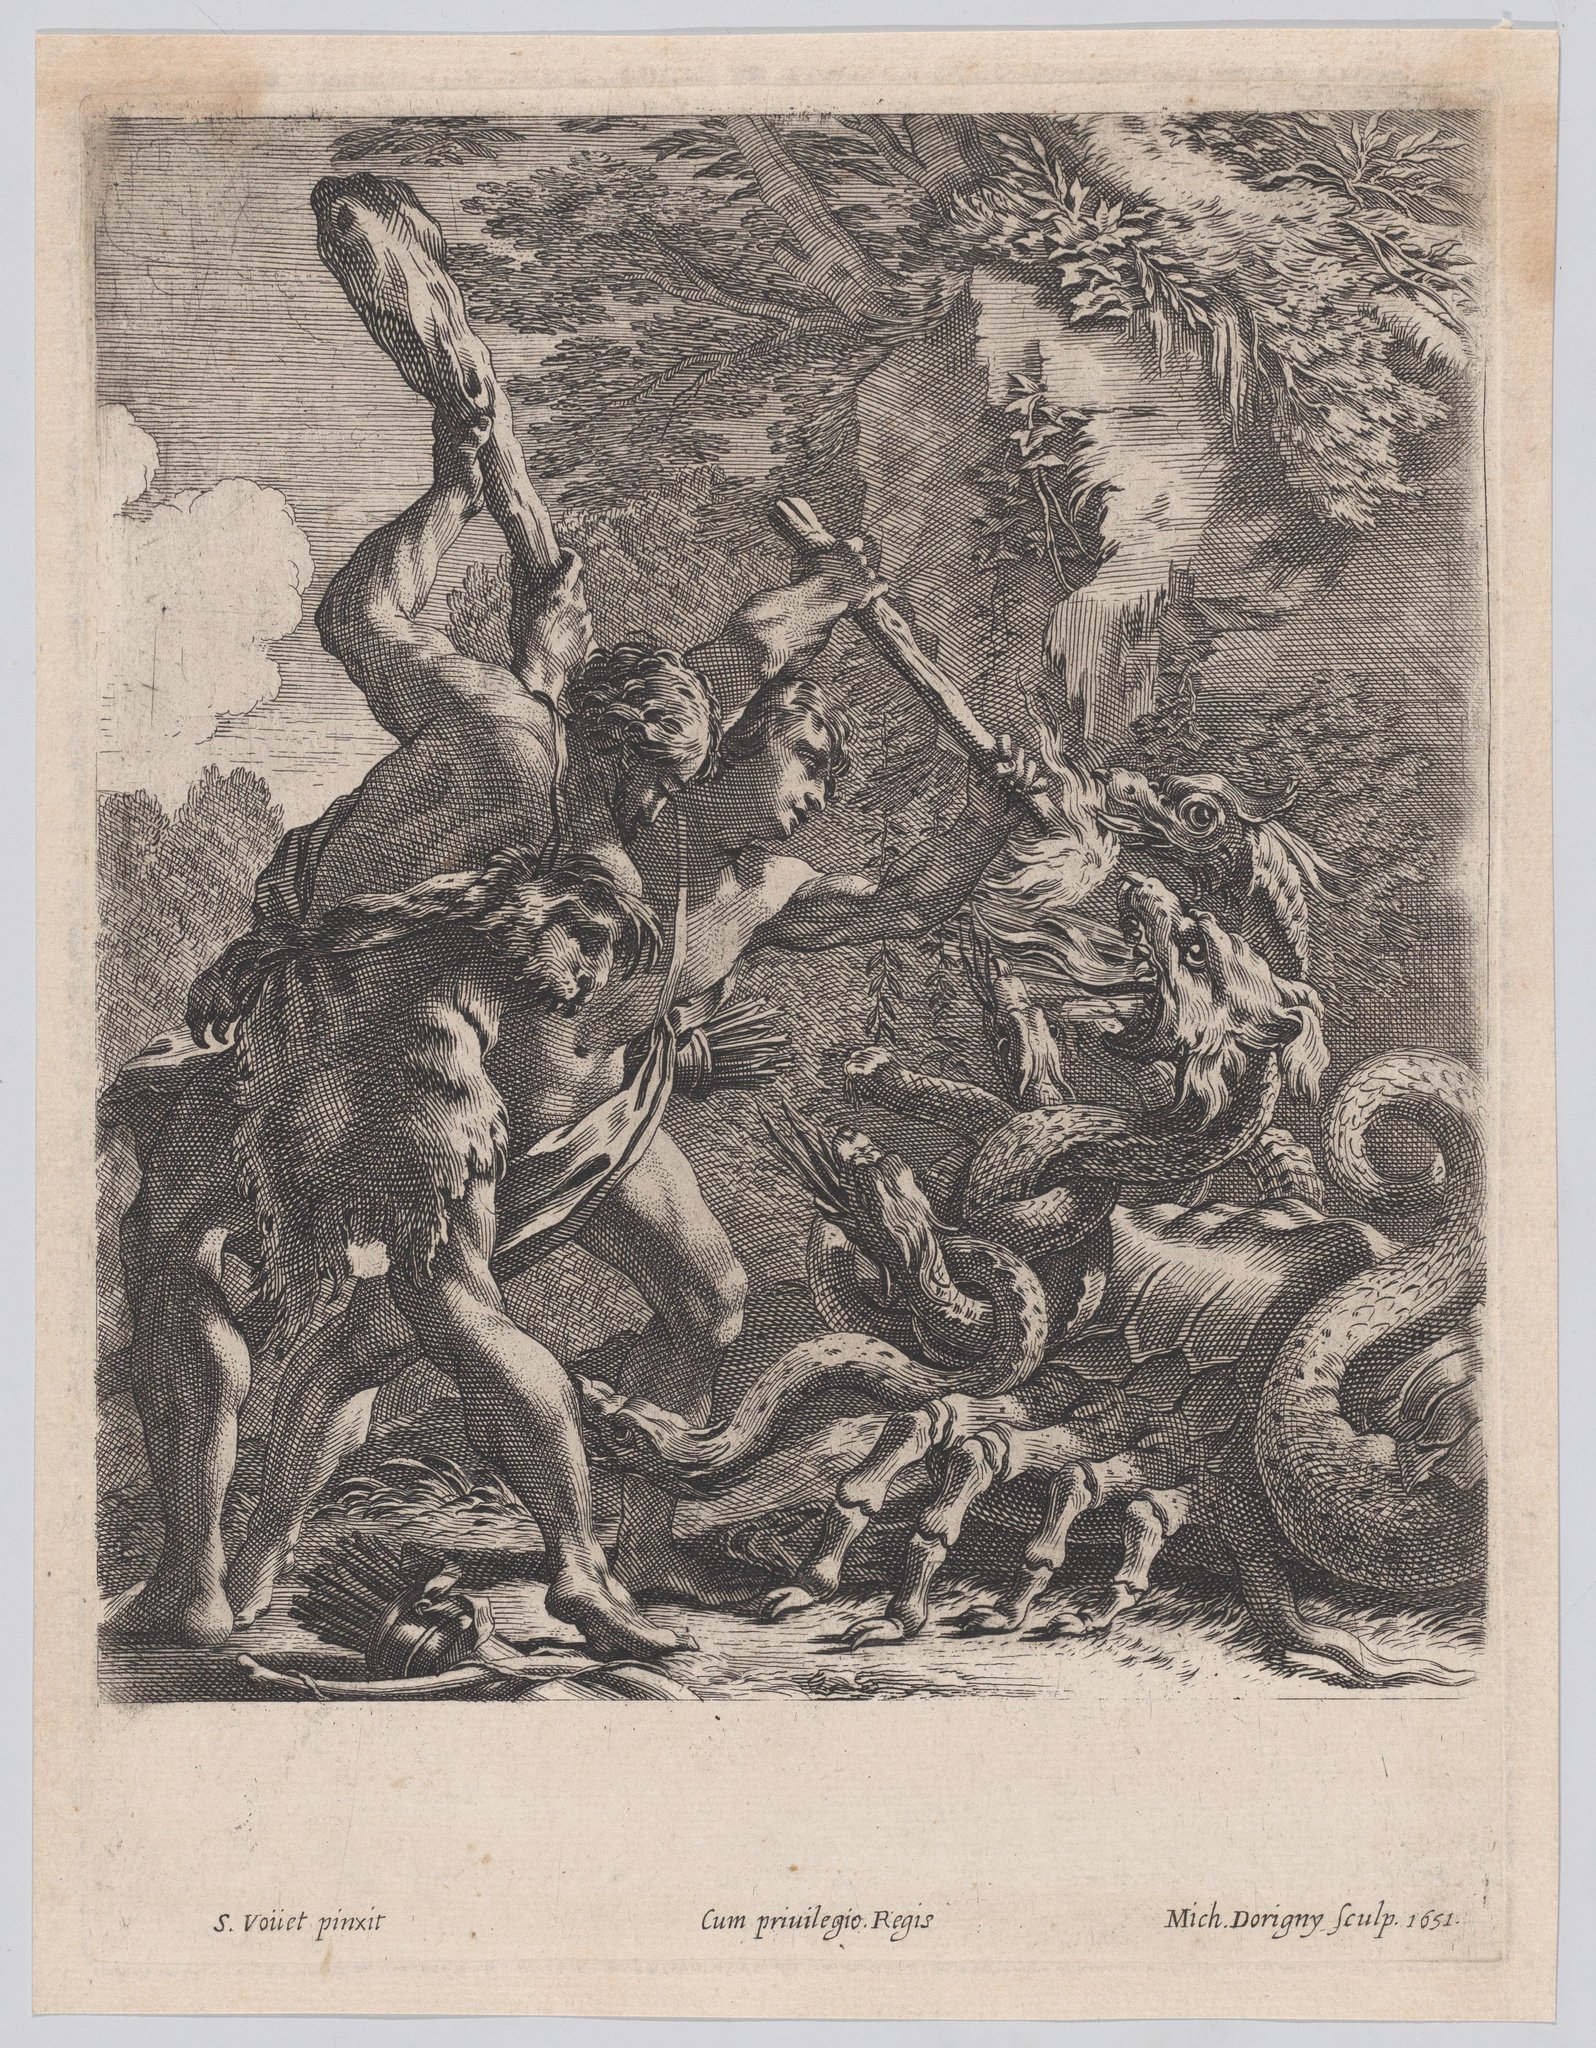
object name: print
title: Hercules and the Hydra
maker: michel dorigny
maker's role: artist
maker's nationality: french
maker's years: 1616-1665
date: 1651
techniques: etching